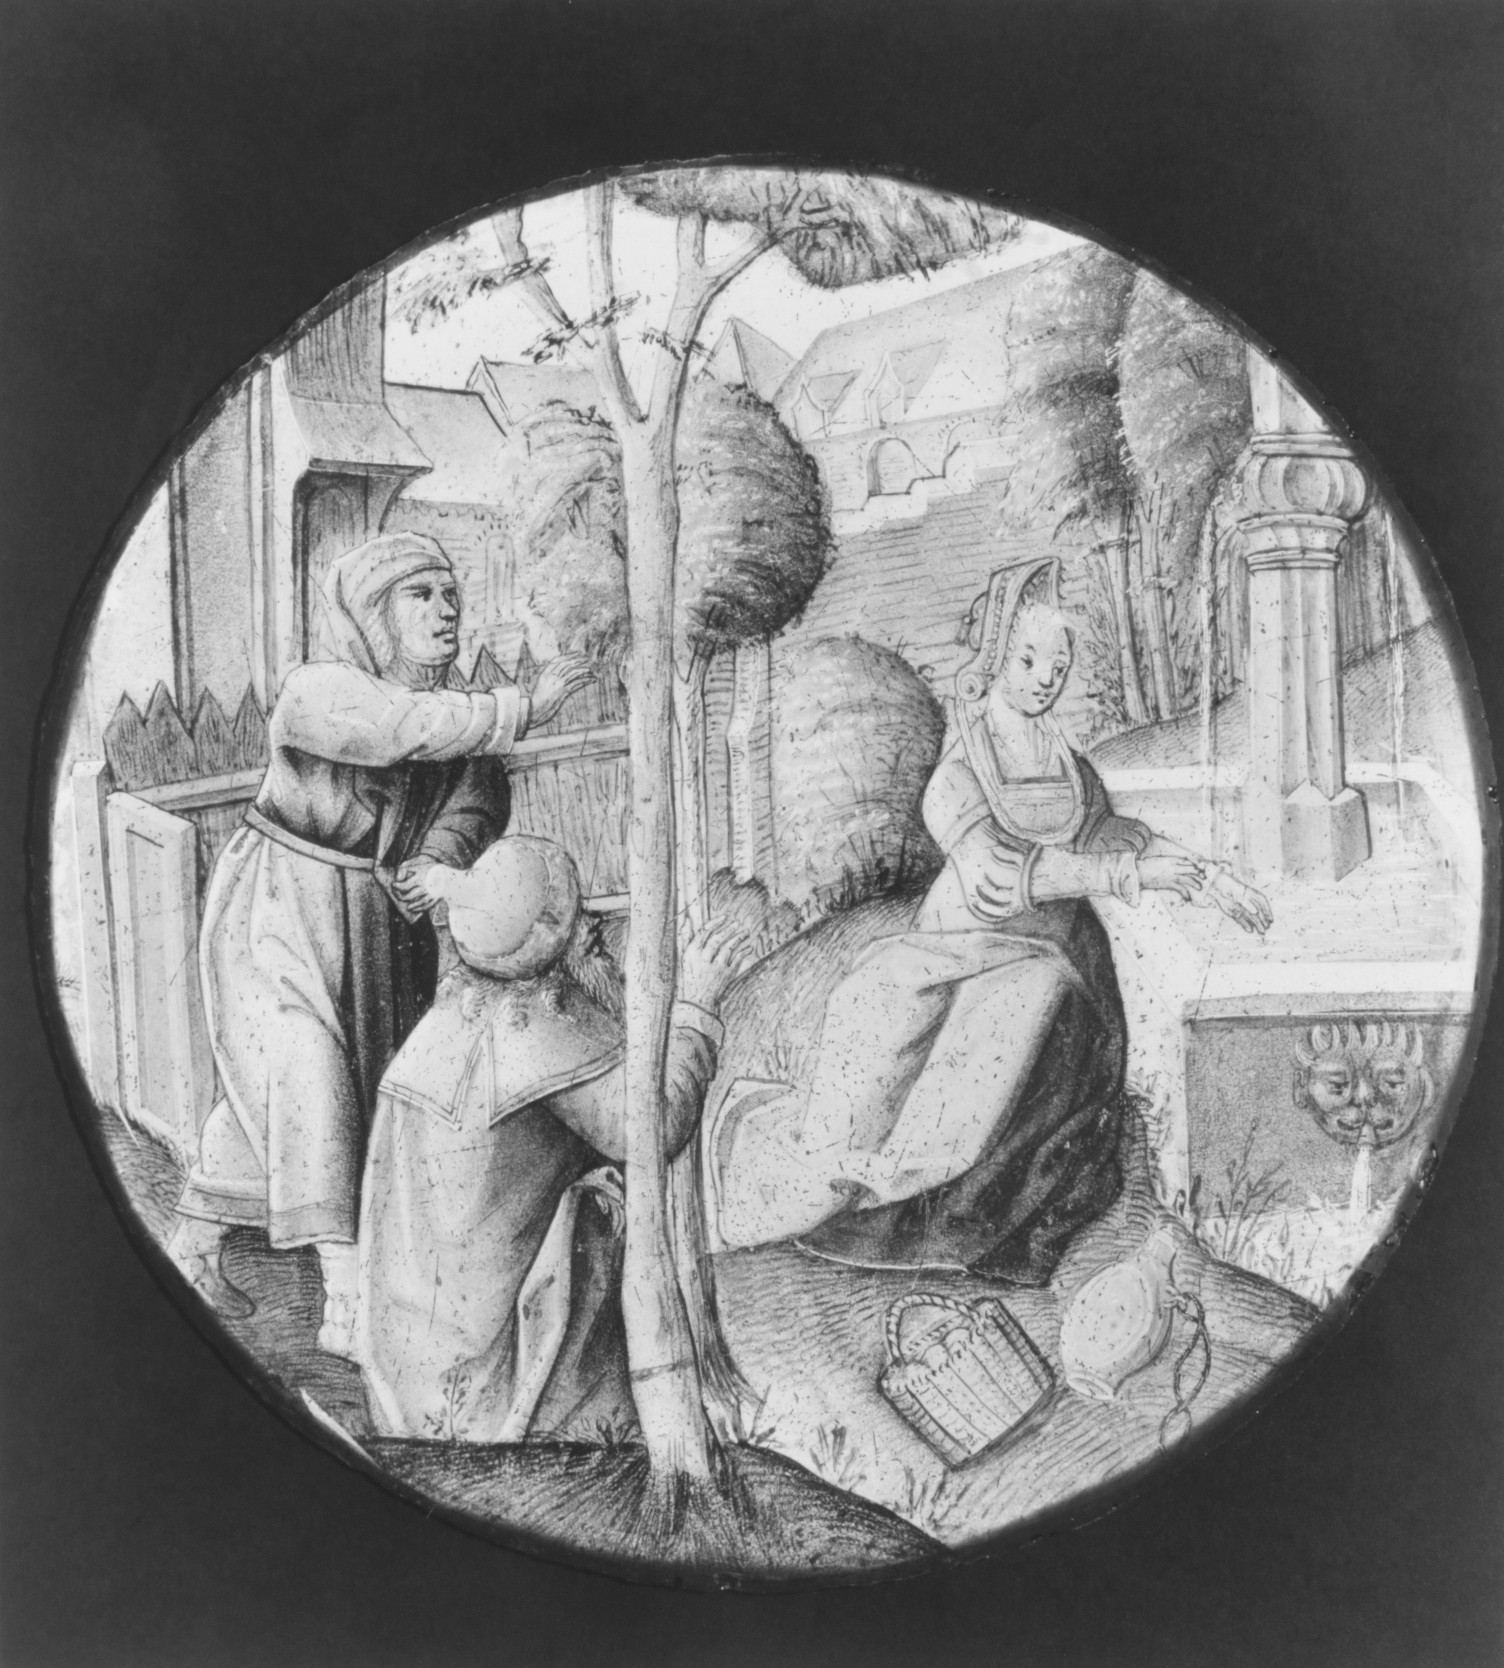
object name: roundel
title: Susannah and the Elders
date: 1501-1600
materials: glass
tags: men,women